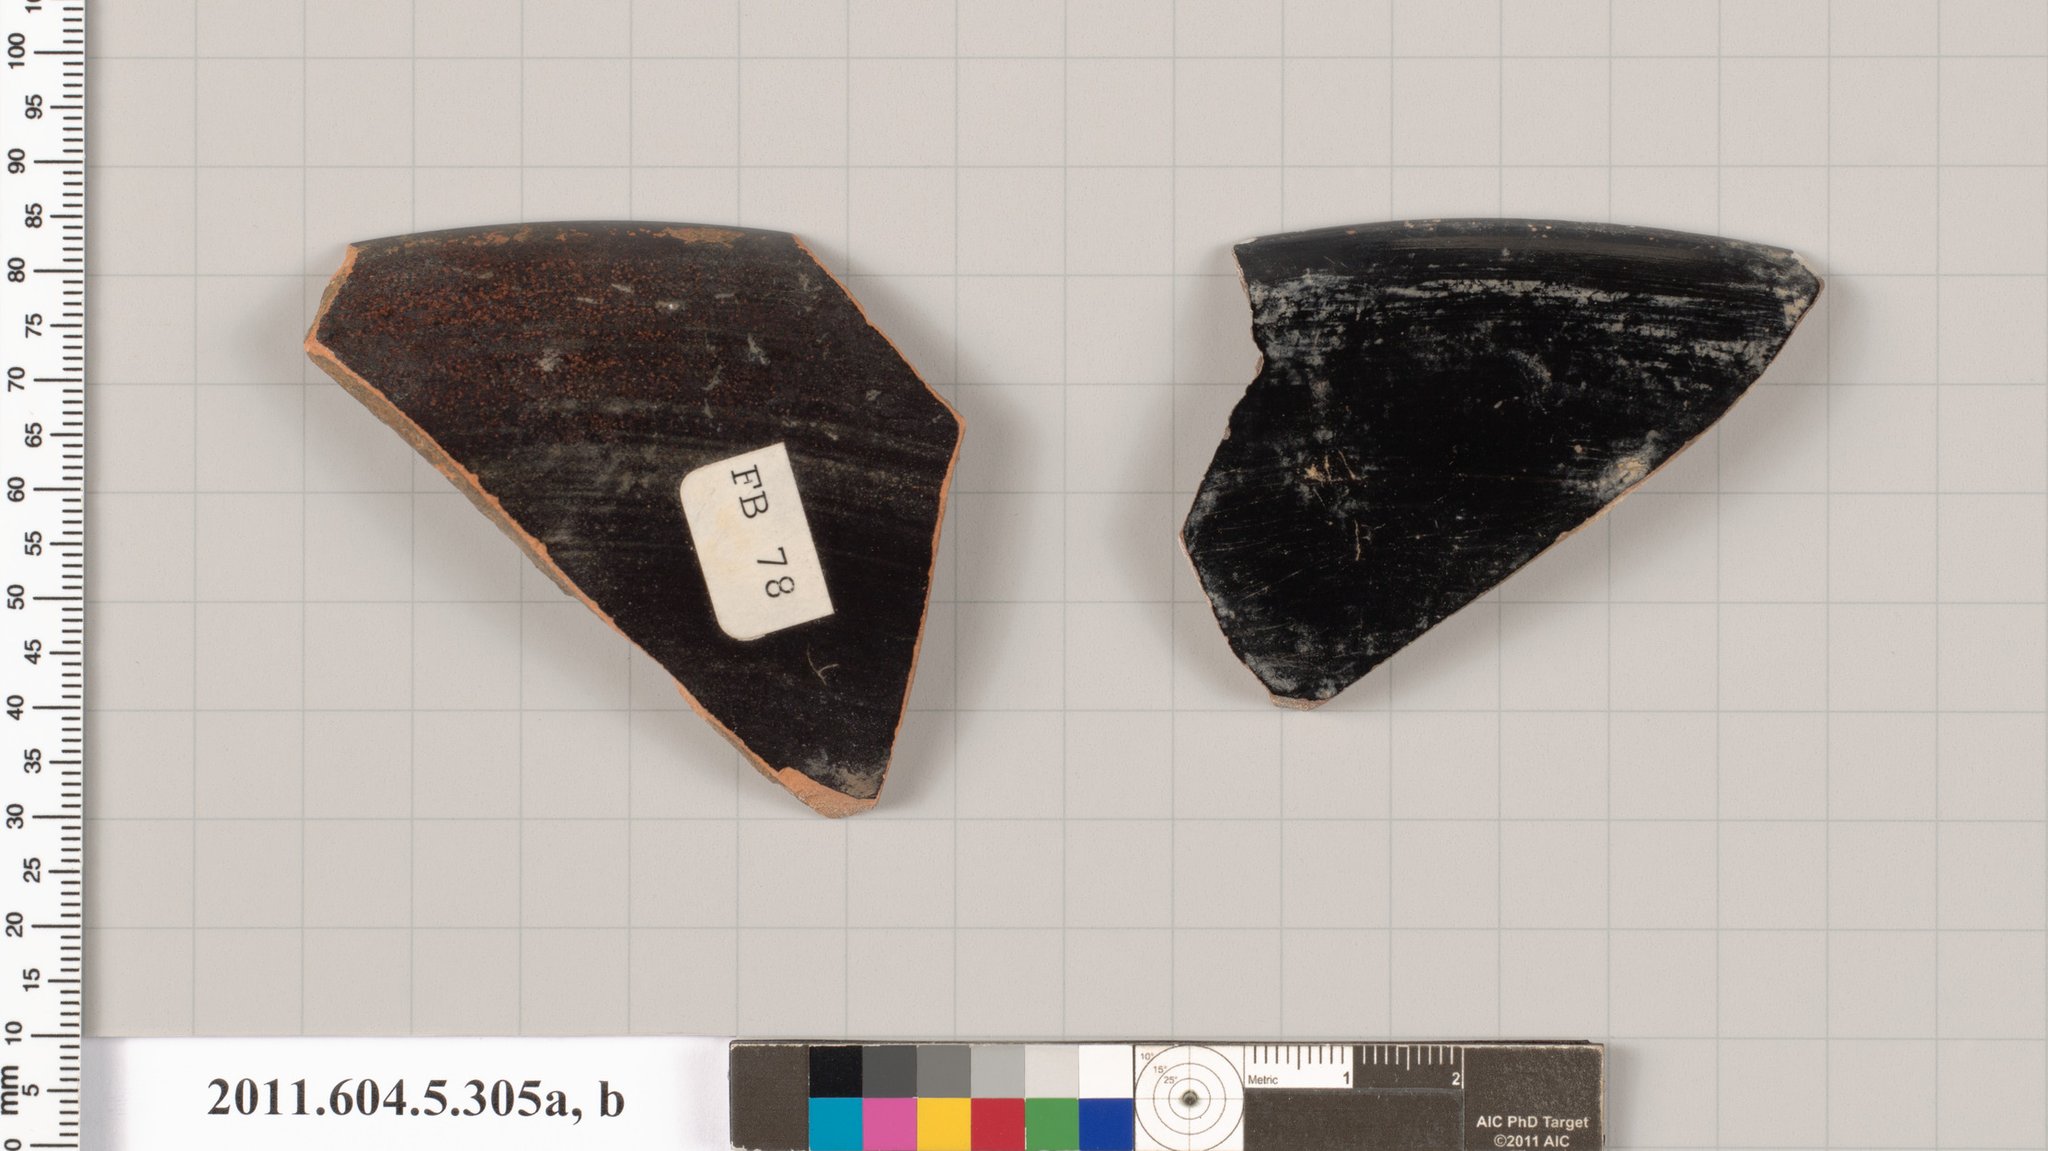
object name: kylix fragment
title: Terracotta rim fragments of kylikes (drinking cups)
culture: greek, attic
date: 600-401 BCE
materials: terracotta